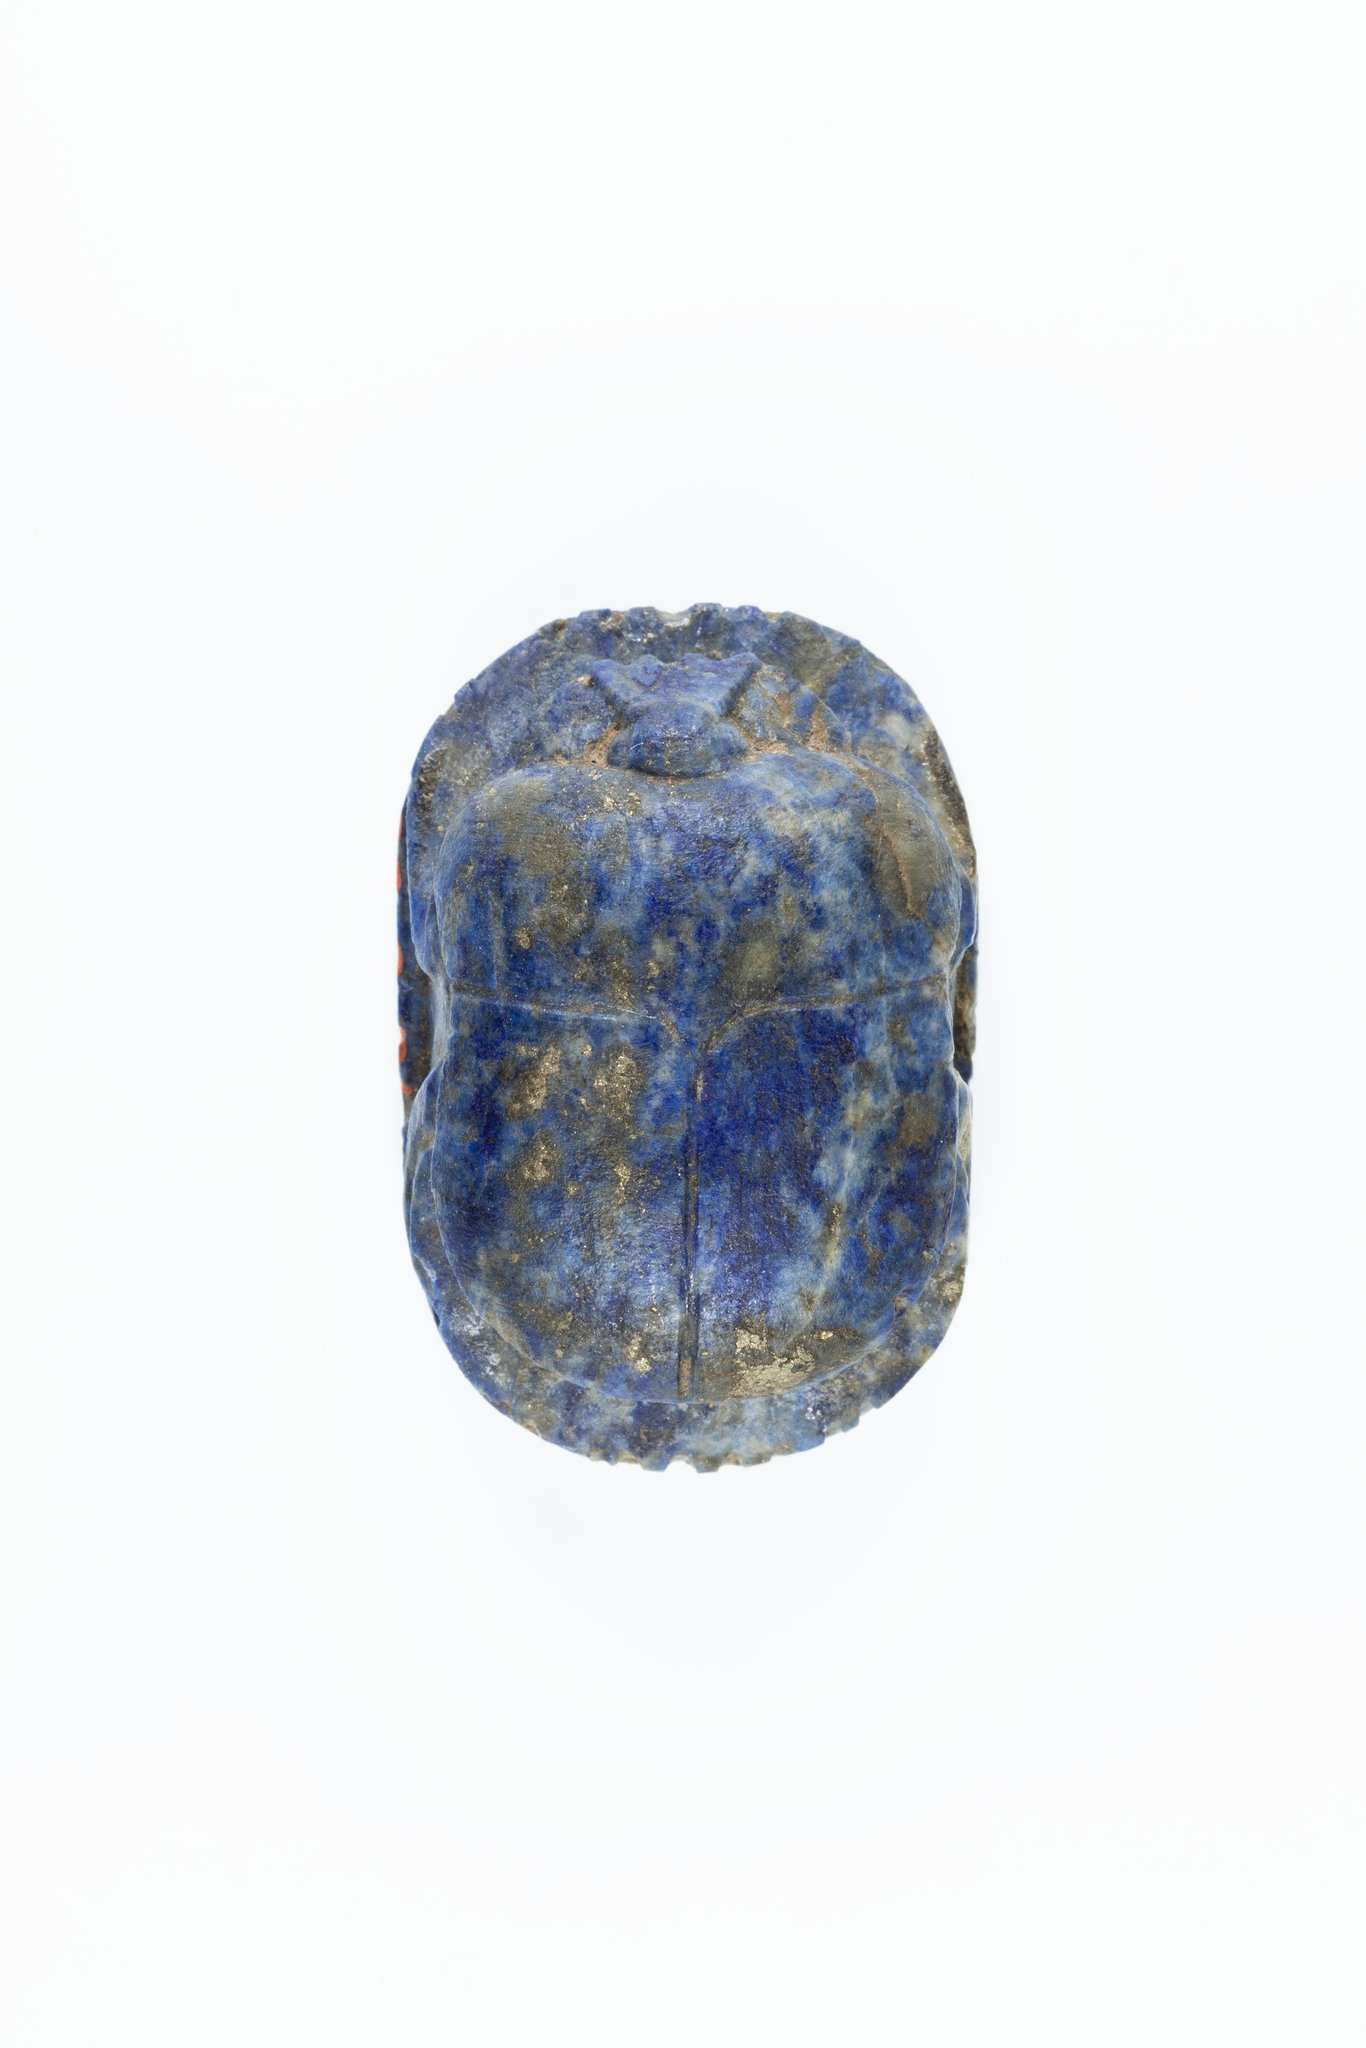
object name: heart scarab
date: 688-525 BCE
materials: lapis lazuli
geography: egypt